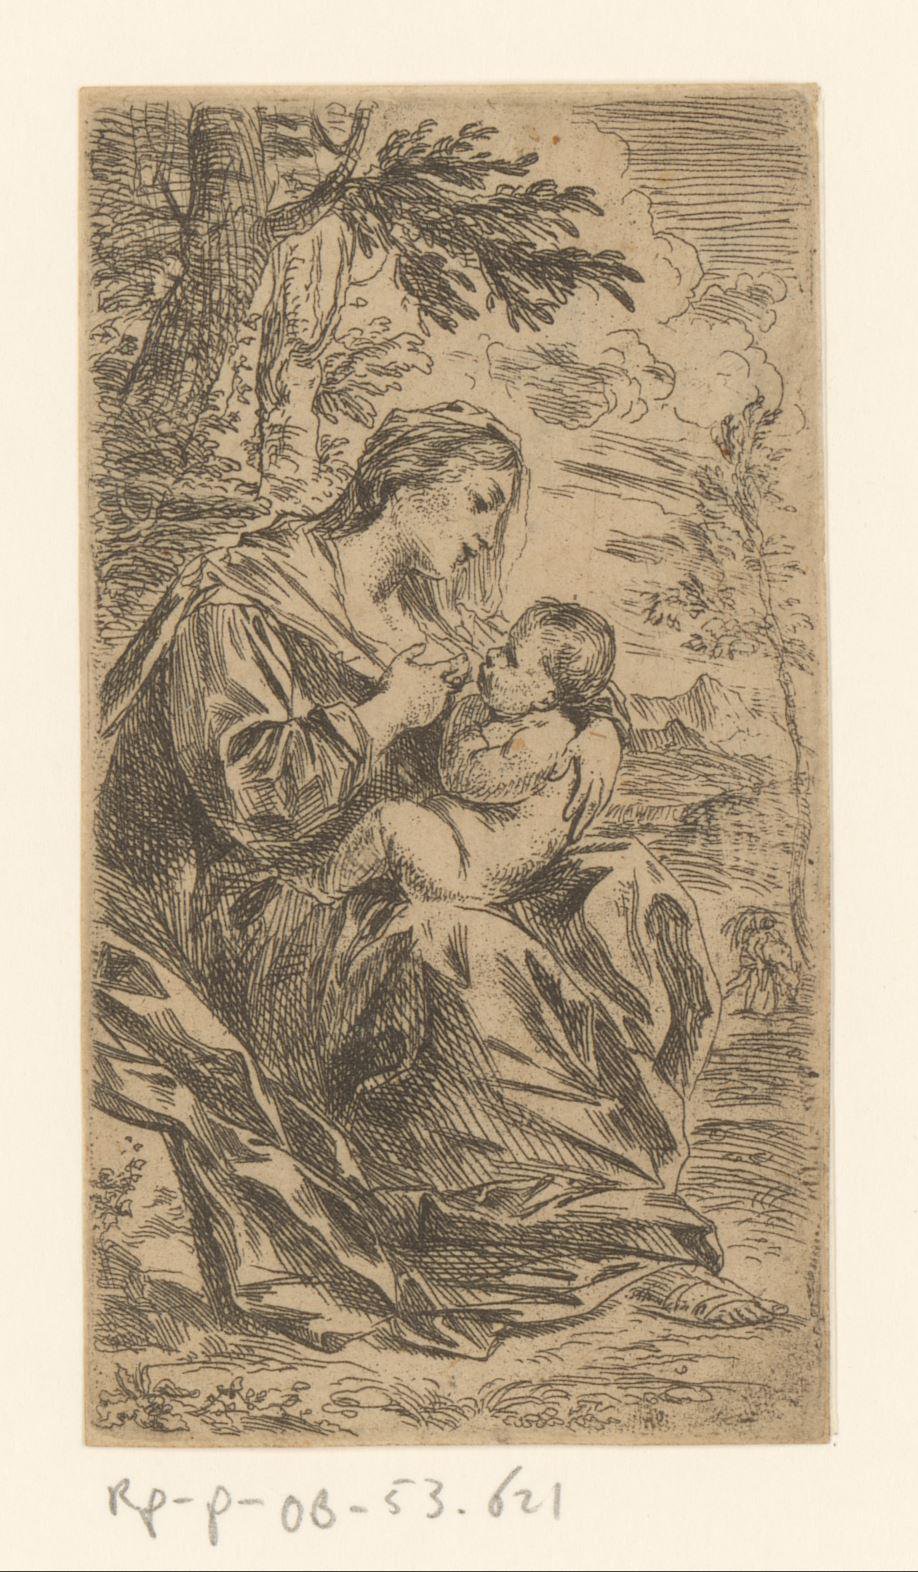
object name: print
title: Madonna met kind voedend in de openlucht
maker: johann anton de peters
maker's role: print maker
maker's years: 1725-1795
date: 1740-1795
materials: paper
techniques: etching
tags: madonna: mary sitting on the ground, the christ-child in her lap